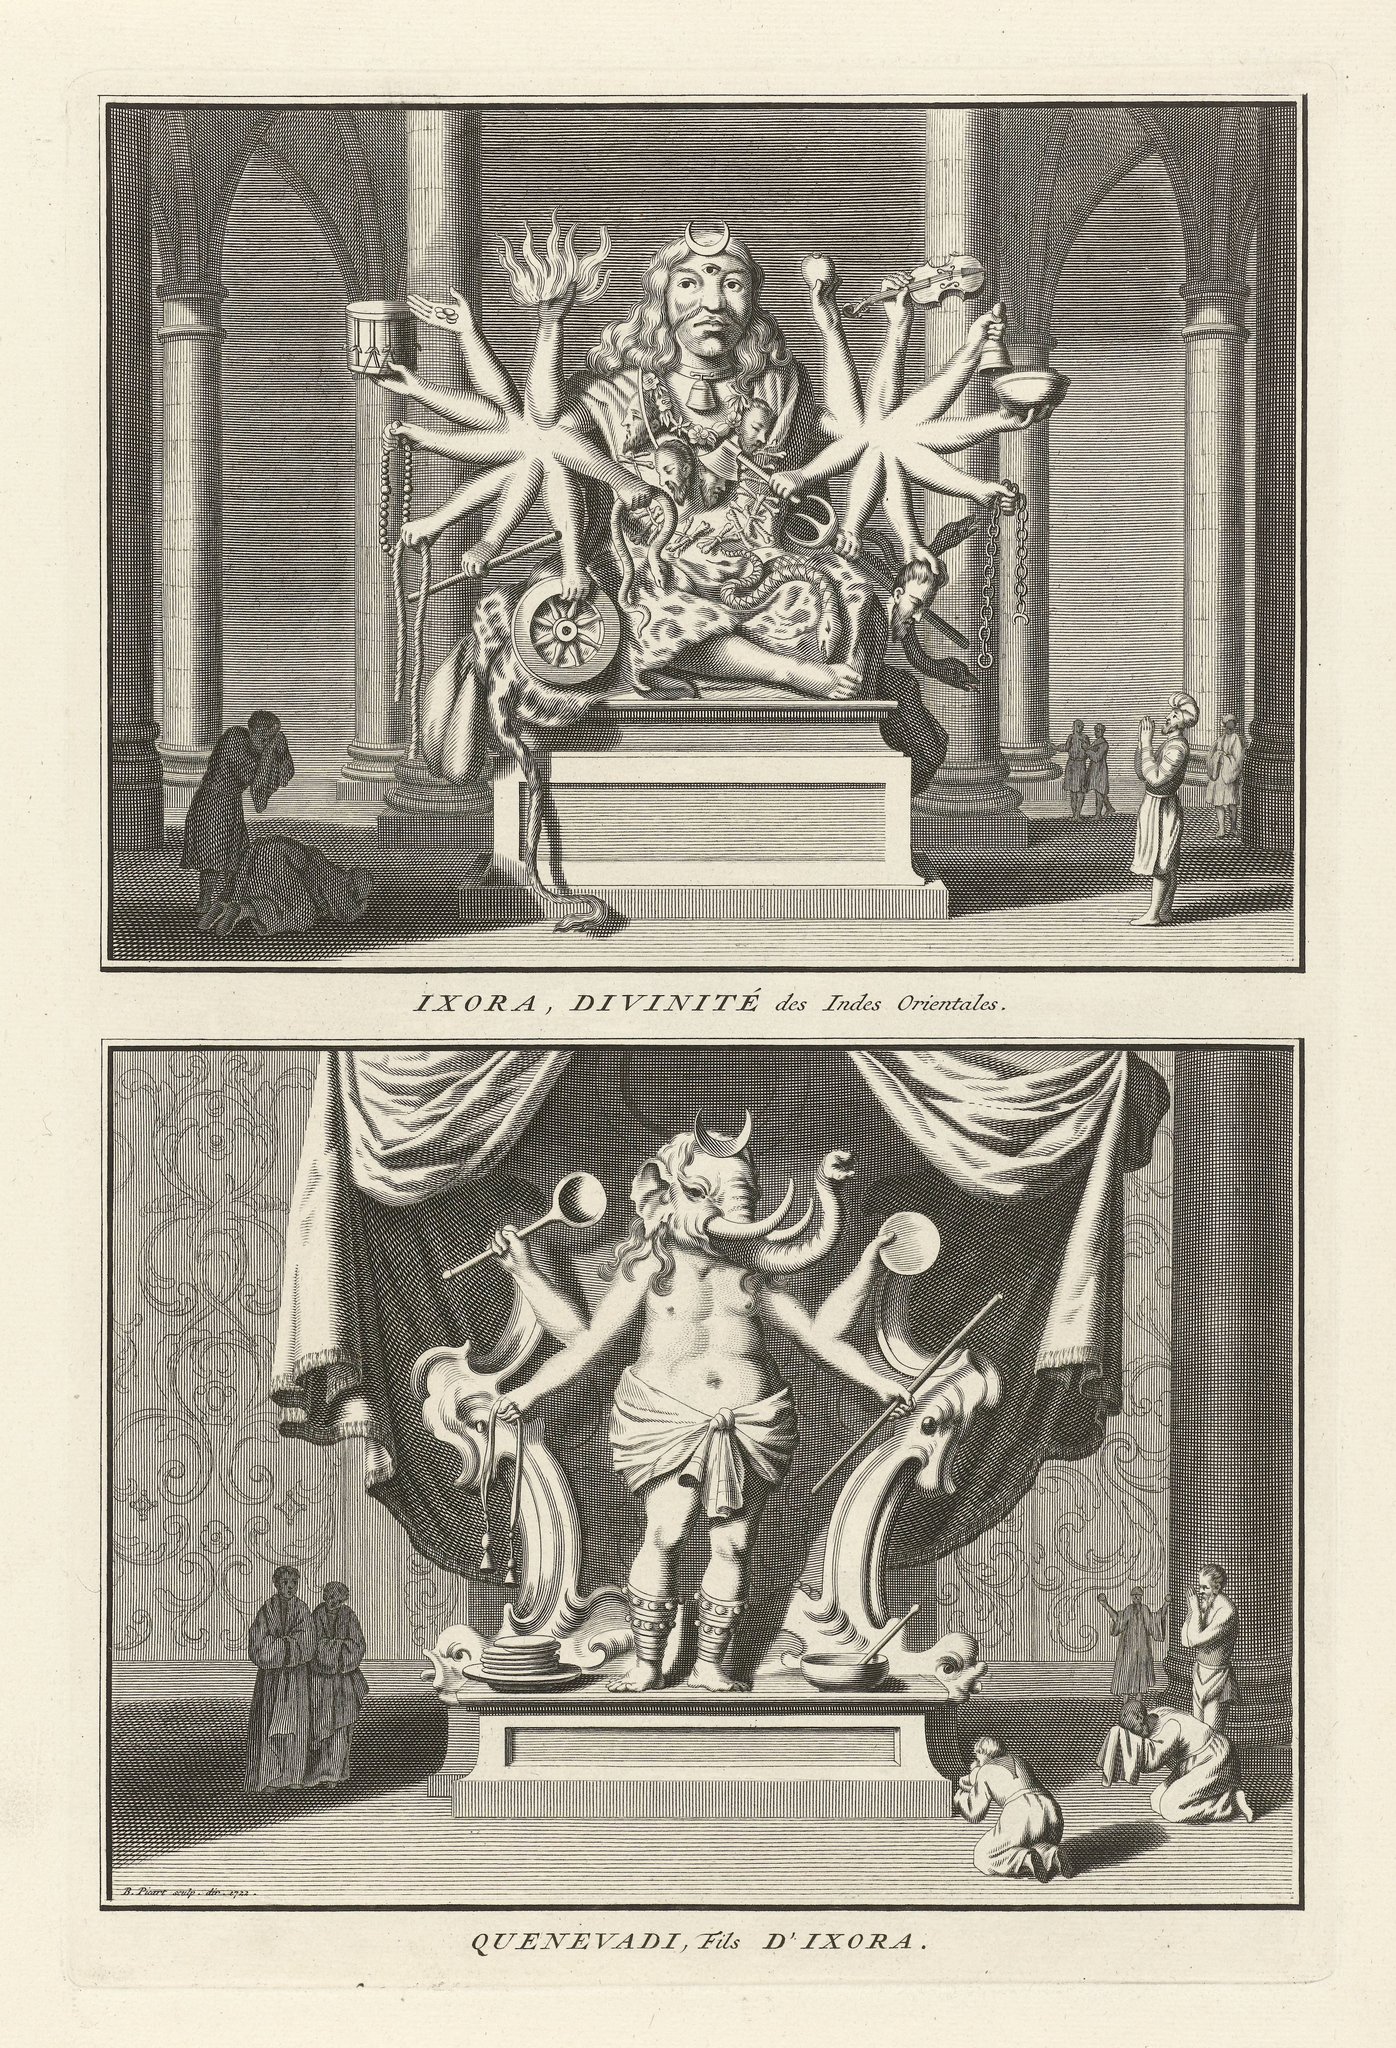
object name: book illustration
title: Beelden van twee Indiase goden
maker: bernard picart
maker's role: draughtsman, print maker, publisher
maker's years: 1673-1733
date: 1722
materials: paper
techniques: engraving, etching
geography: amsterdam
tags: shiva, conceptions and ideas visualized ~ hinduism, buddhism, jainism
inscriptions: collector's mark: Lugt 2233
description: Tweede staat van deze prent gebruikt als illustratie in: Picart, Bernard. Naaukeurige beschryving der uitwendige godtsdienst-plichten, kerk-zeden en gewoontens van alle volkeren der waereldt. [Vertaald in het Nederlands door] Moubach, Abraham. Den Haag, Amsterdam, Rotterdam: Rutgert Alberts, Hermannus Uytwerf, Jan Daniel Beman, Isaac van der Kloot, 1727-1738.